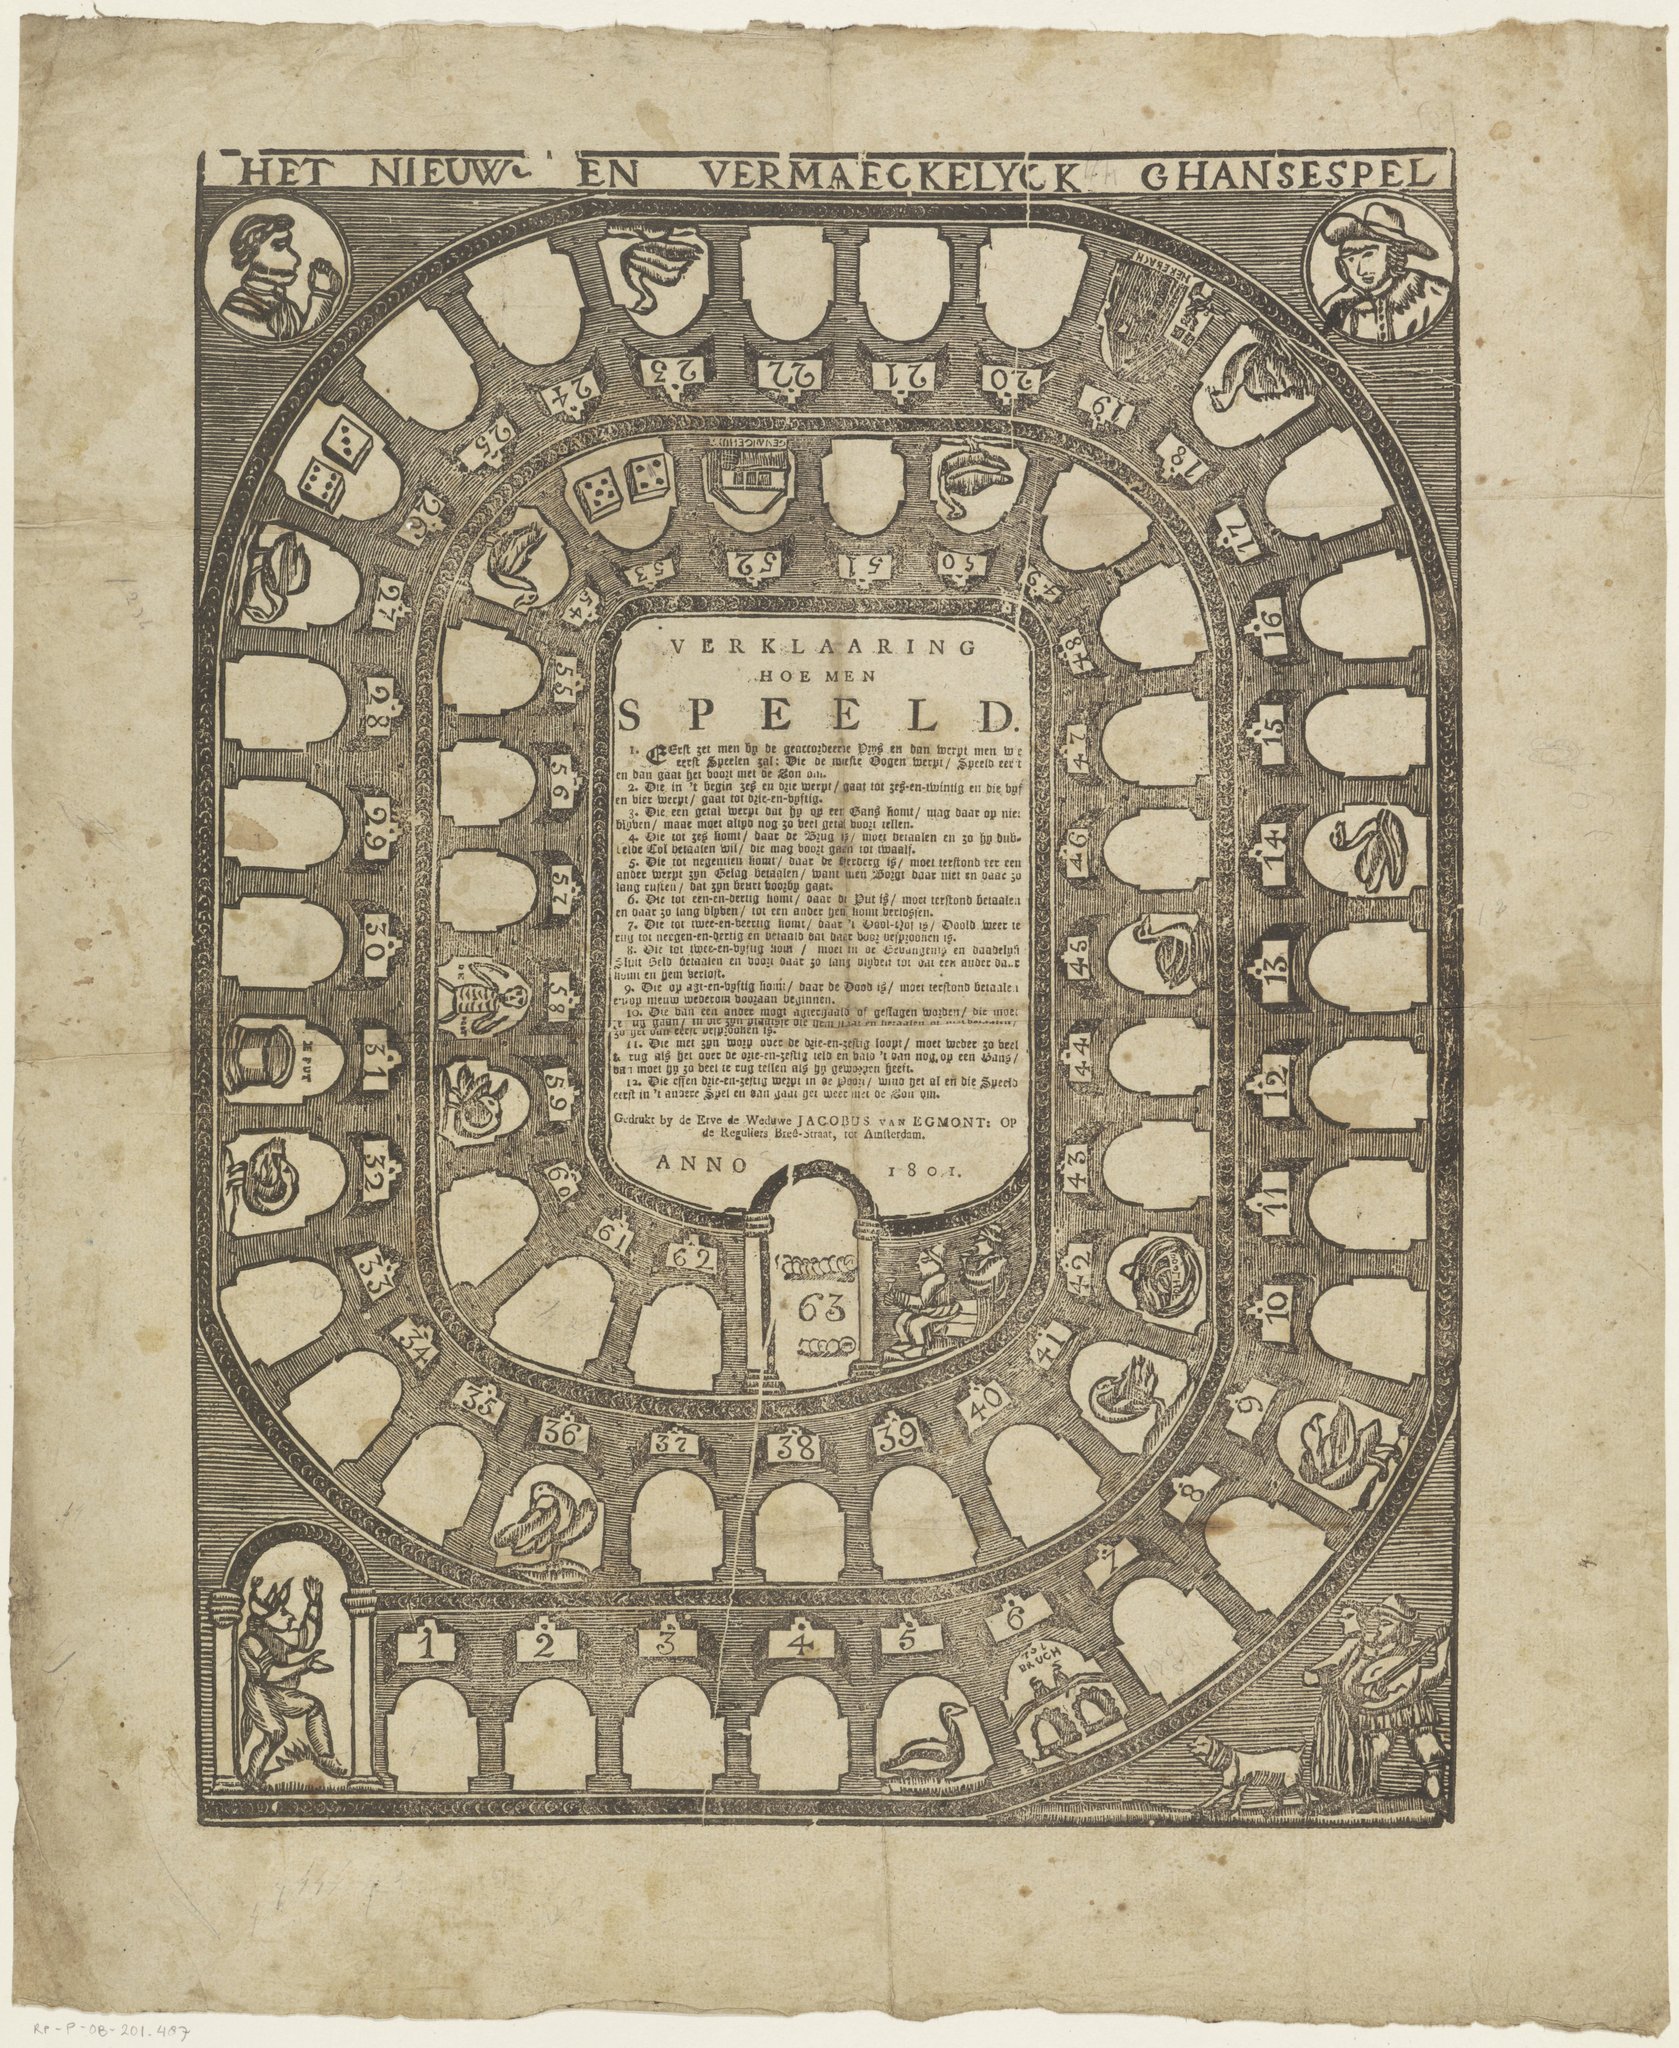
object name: gameboard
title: Het nieuw en vermaeckelyck ghansespel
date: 1801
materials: paper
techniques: letterpress printing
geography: amsterdam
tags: goose-game, board-games of chance, board-games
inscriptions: collector's mark: Lugt 2760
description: Ganzenbordspel met vakjes genummerd van 1 tot en met 63. In enkele vakjes voorstellingen van ganzen. In het grote centrale vak de spelregels. Titel in de bovenmarge.